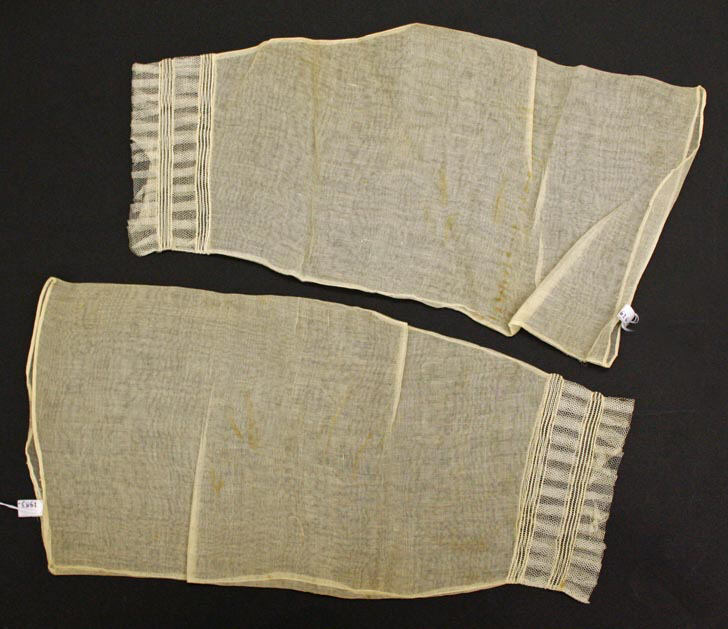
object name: undersleeves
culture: american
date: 1872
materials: cotton